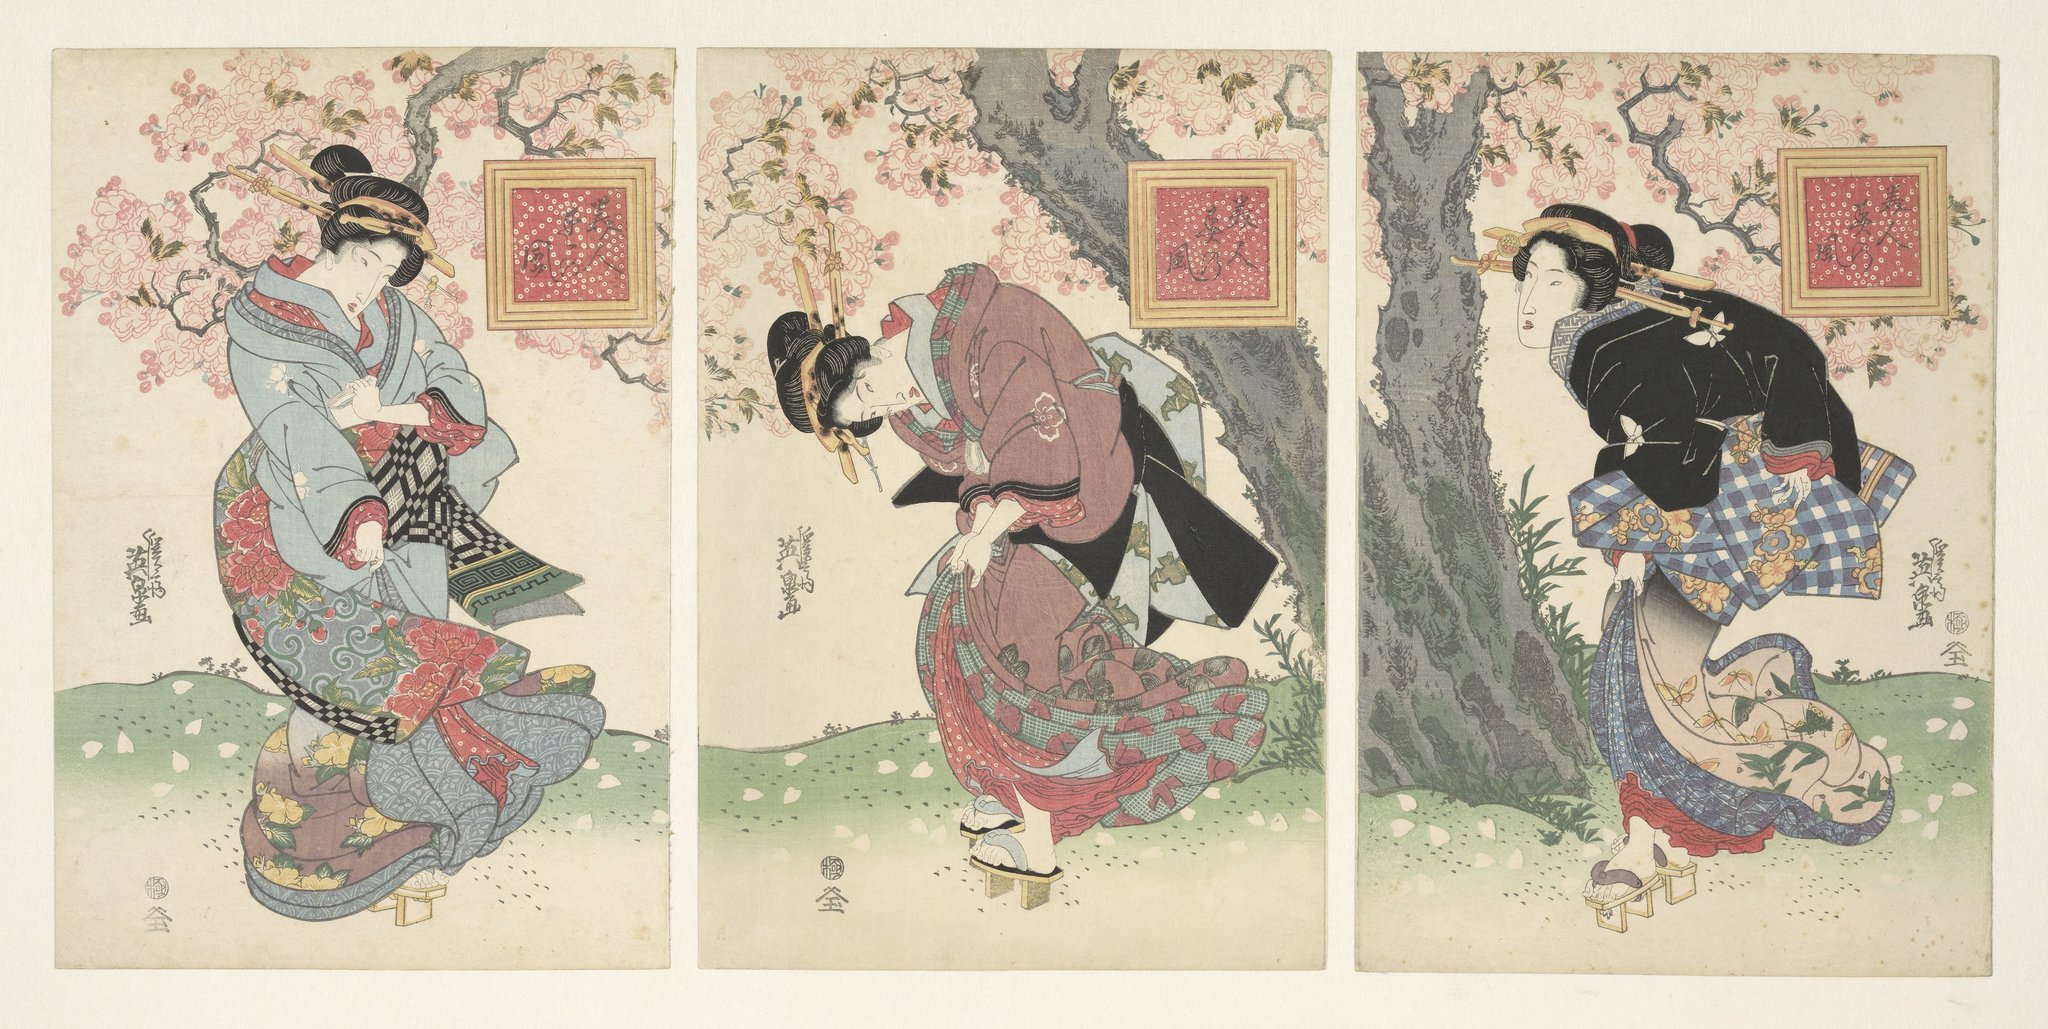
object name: triptych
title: Bijin haru no kaze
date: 1828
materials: paper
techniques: woodcut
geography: japan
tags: trees, adult woman (+ three persons)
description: Drie vrouwen in de wind bij een boom vol met roze kersenbloesem